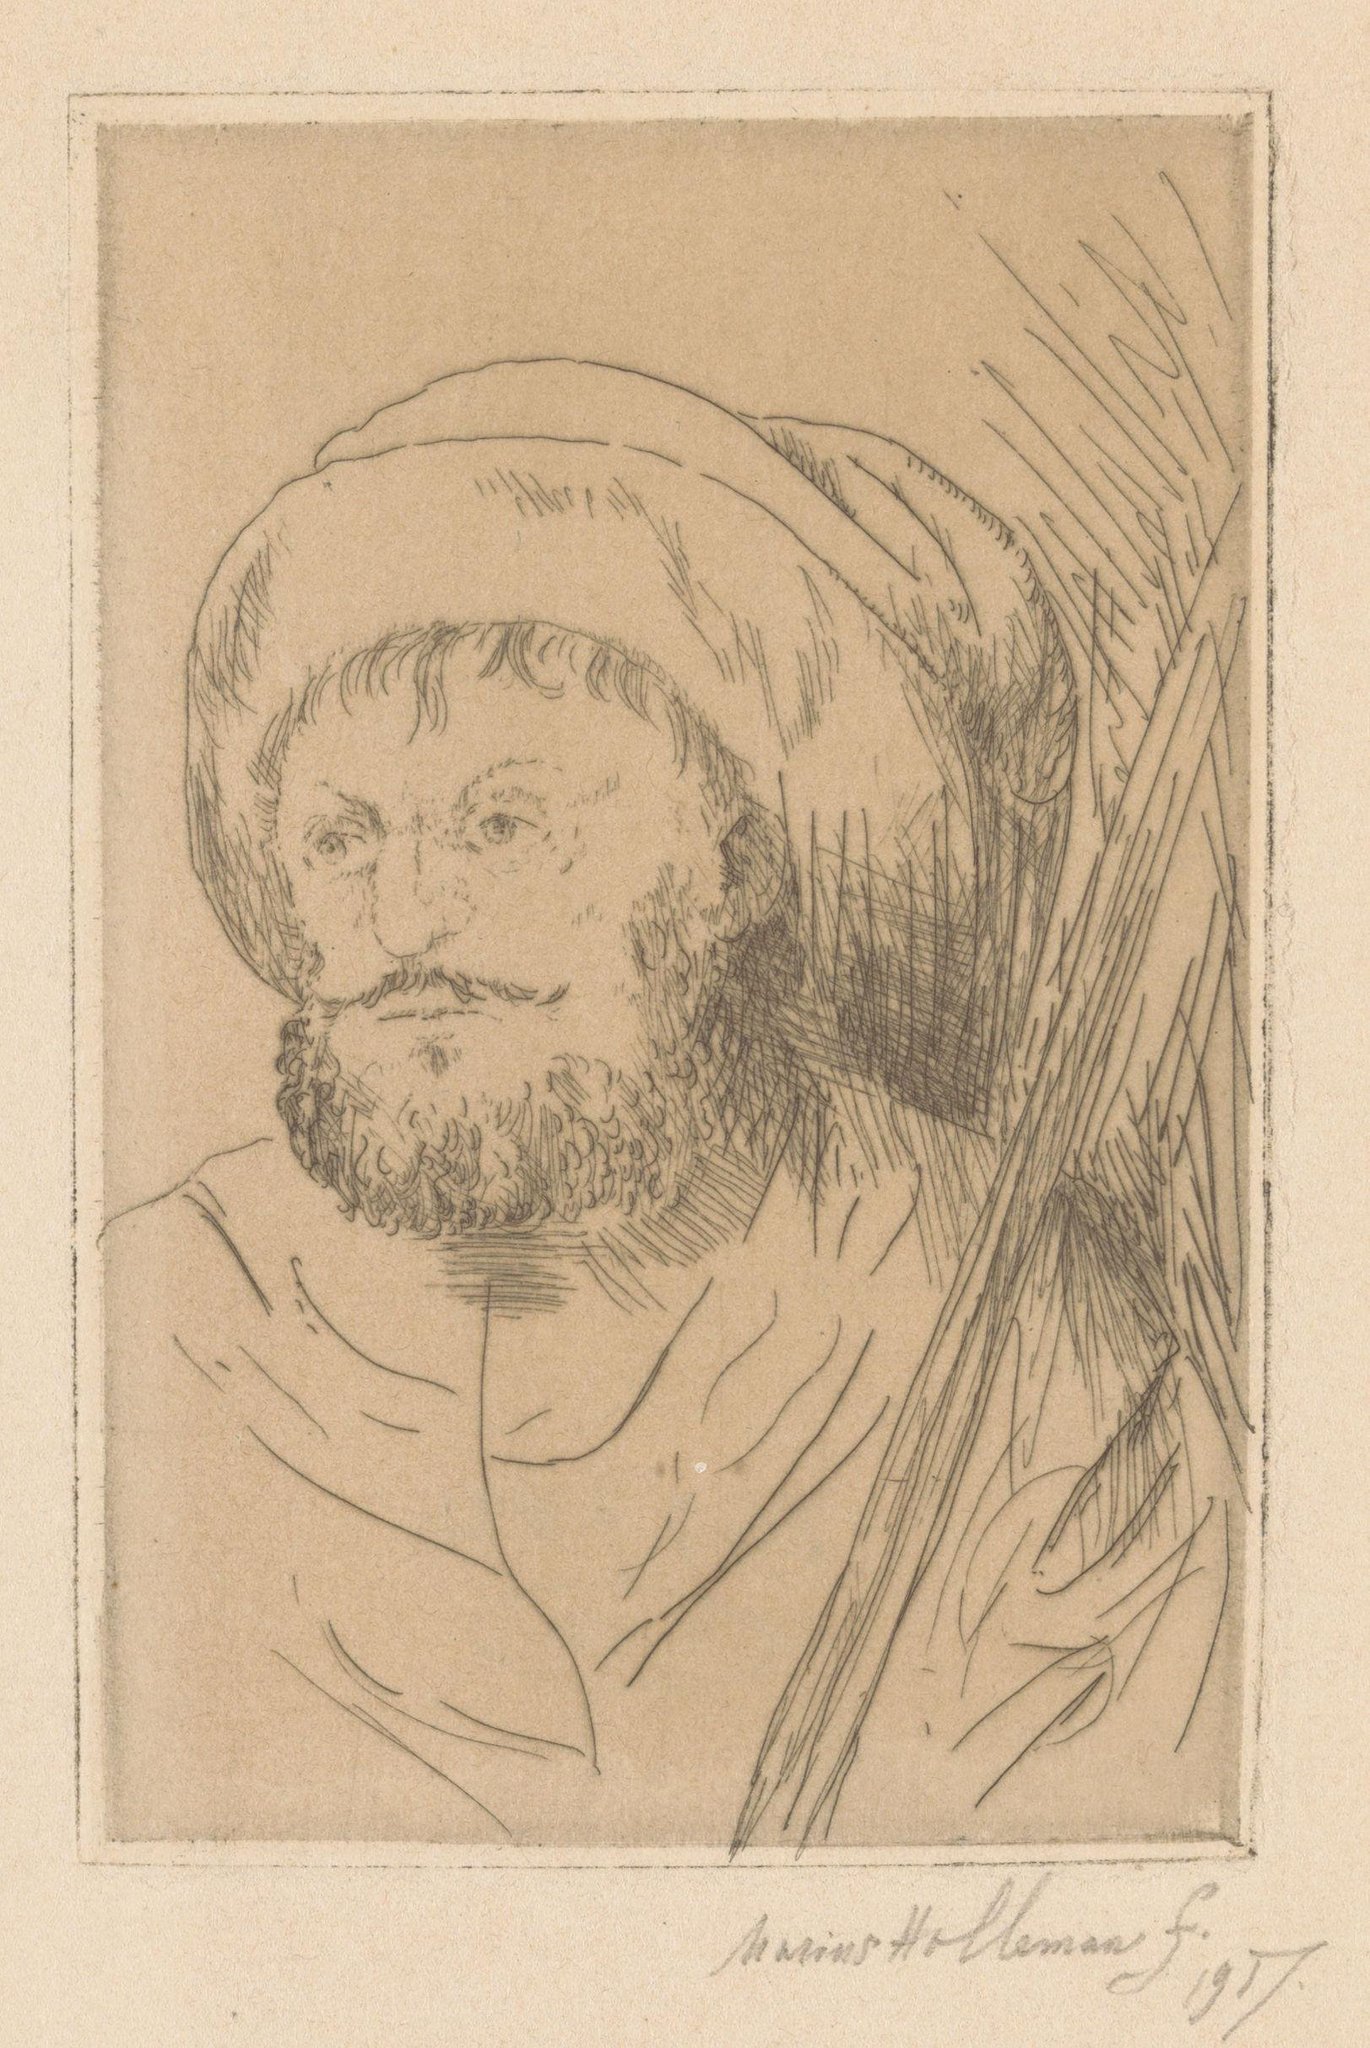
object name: print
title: Man met stok en zeventiende-eeuwse hoed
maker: marius holleman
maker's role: draughtsman, print maker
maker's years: 1878-1926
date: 1917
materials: paper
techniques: etching, intaglio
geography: groningen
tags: walking-stick, staff, head-gear: hat, beard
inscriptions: collector's mark: Lugt 2228